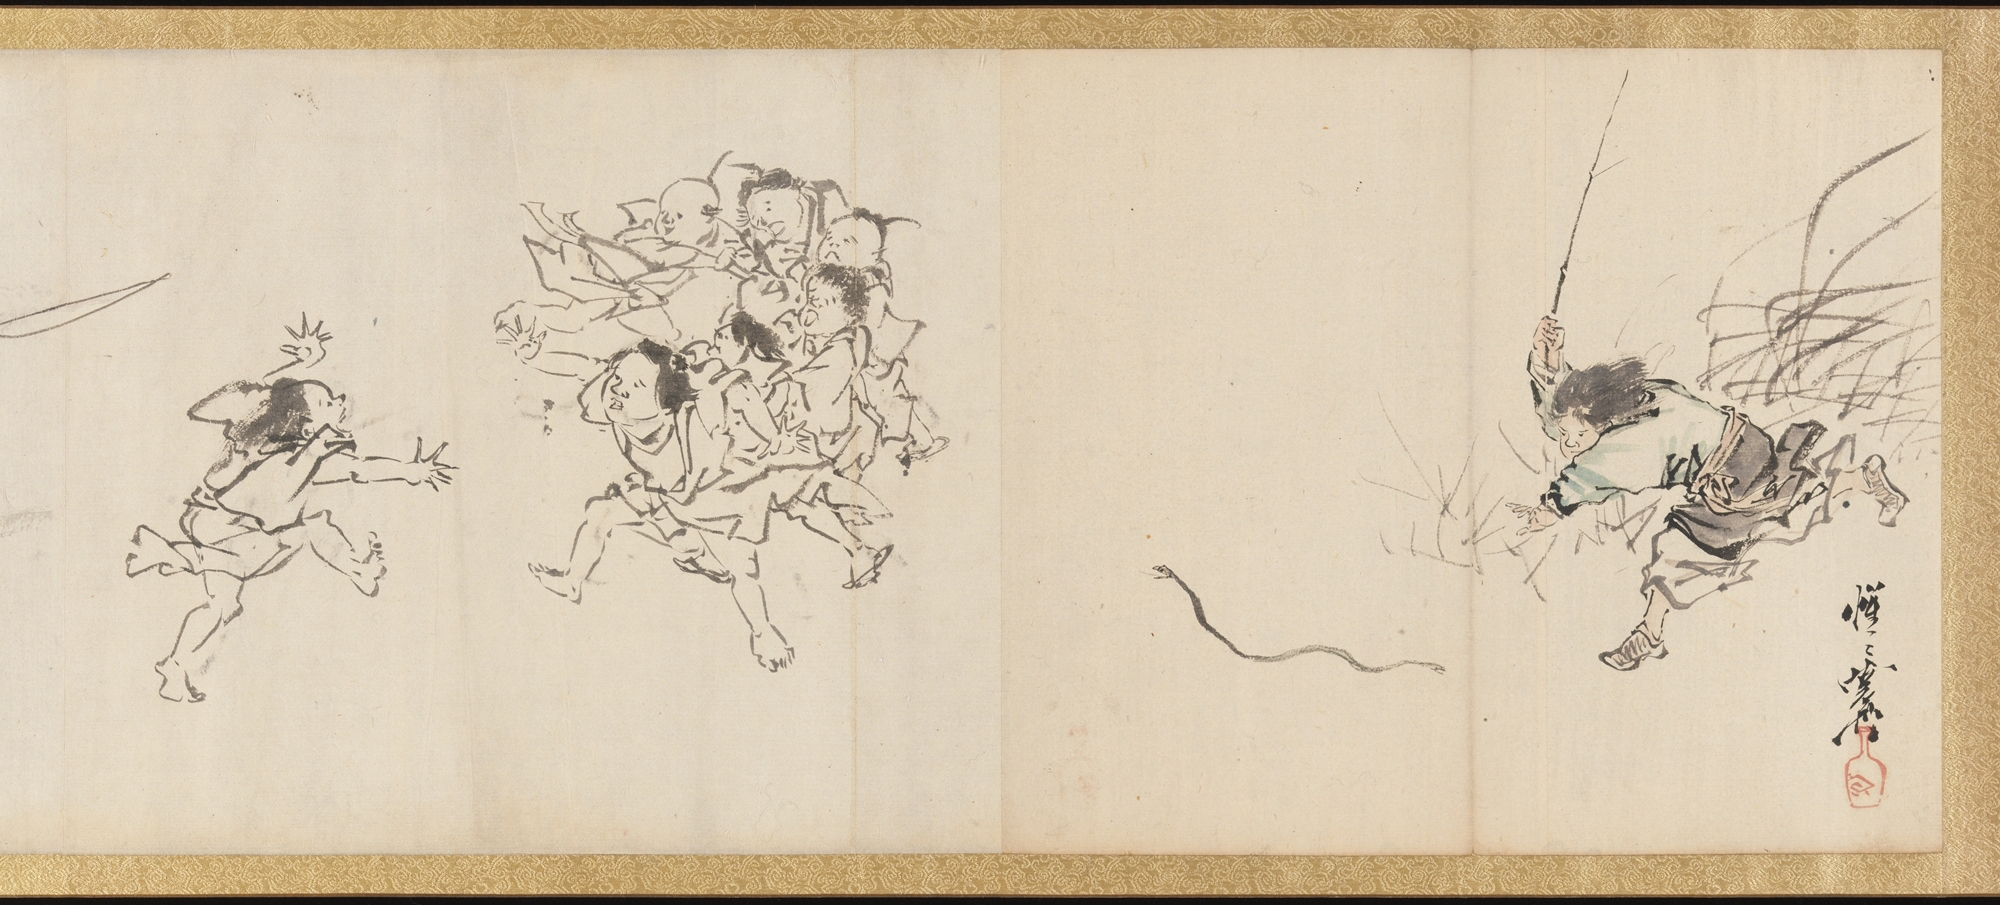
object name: handscroll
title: Frolicking Figures and Animals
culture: japanese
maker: kawanabe kyōsai 河鍋暁斎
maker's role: artist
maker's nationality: japanese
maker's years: 1831-1889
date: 1801-1900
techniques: drawing, wash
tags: boys,men,buffalos,foxes,snakes